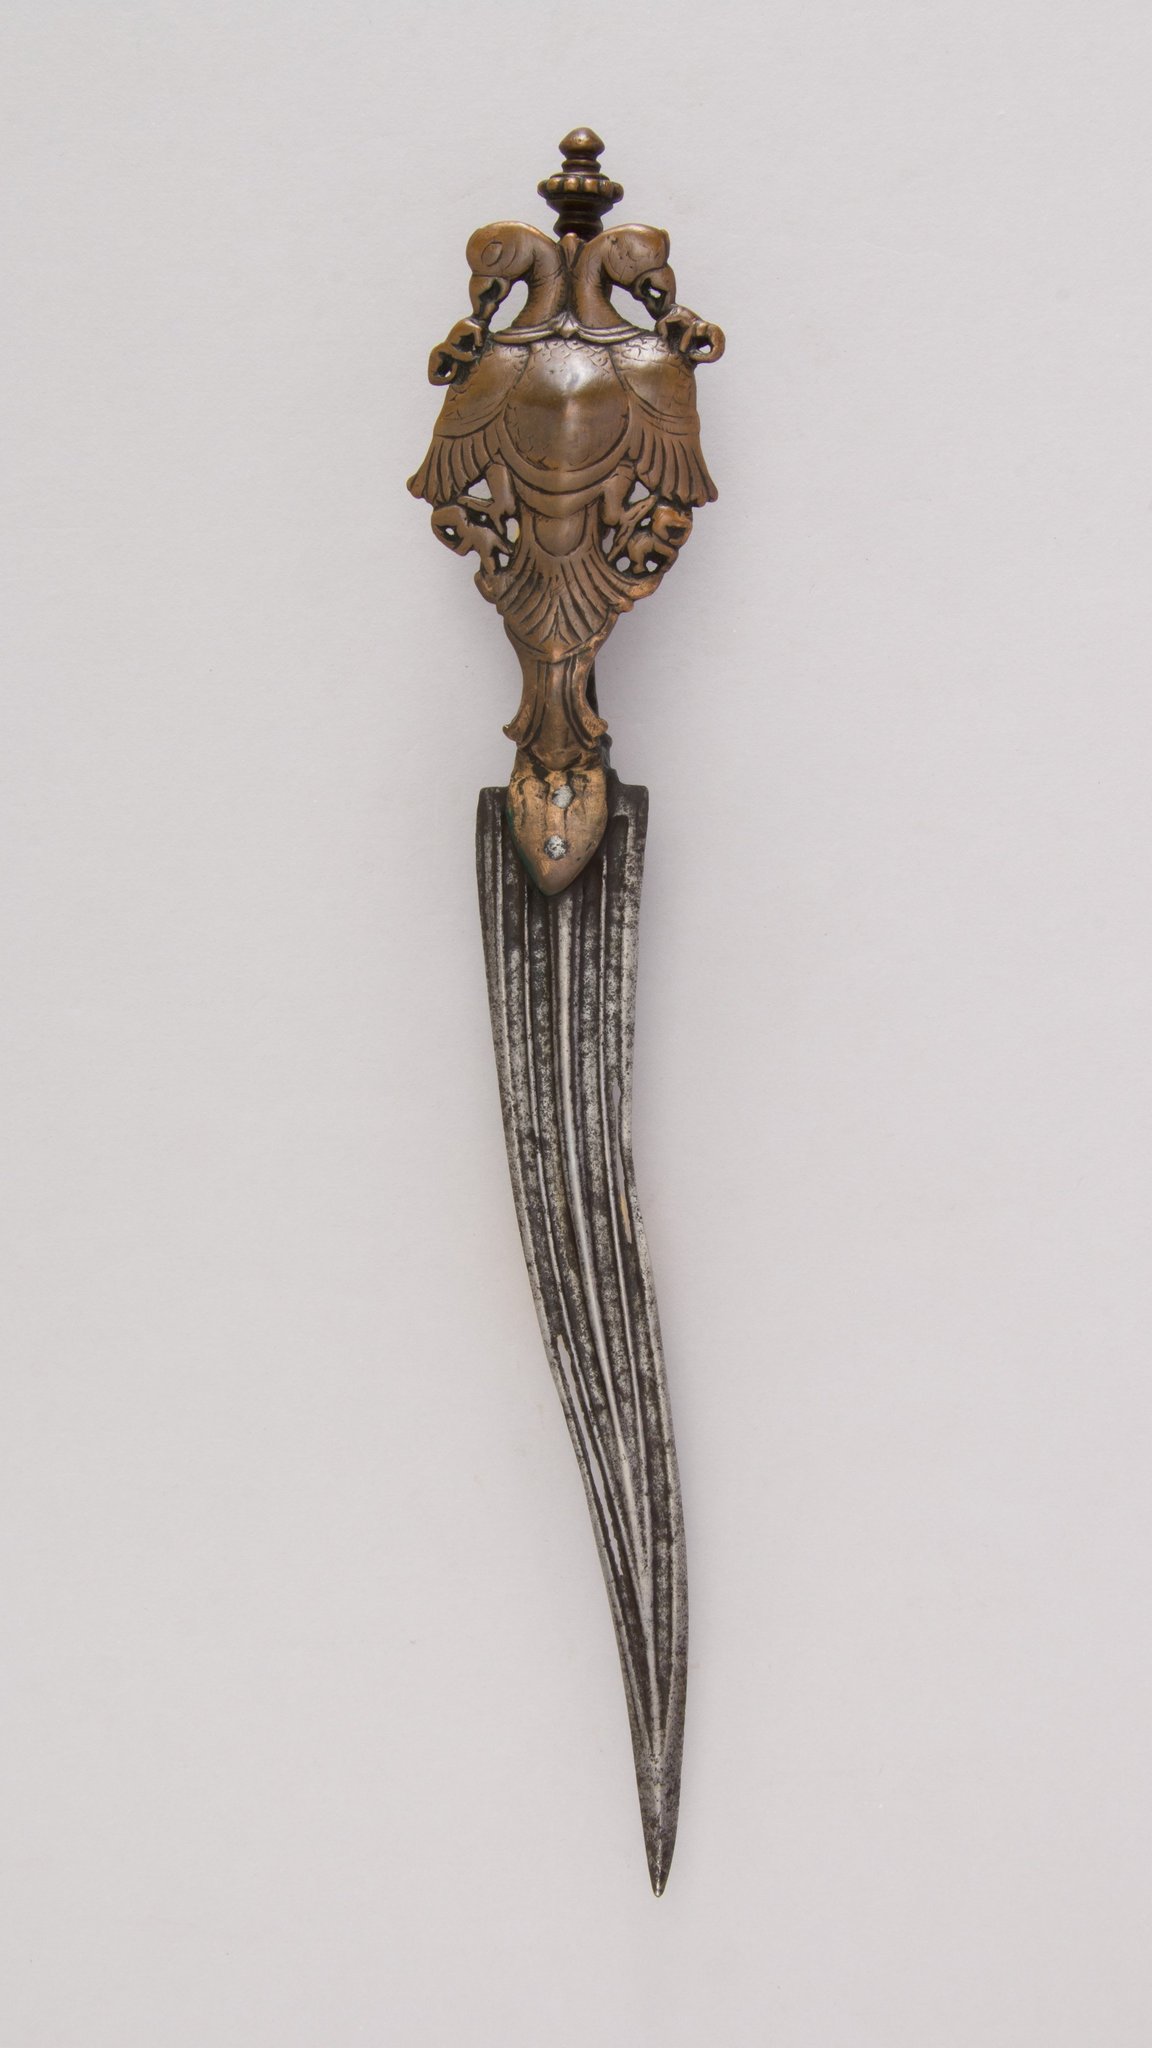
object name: dagger bichuwa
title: Dagger (Bichuwa)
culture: indian, thanjavur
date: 1601-1700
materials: copper, steel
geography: india